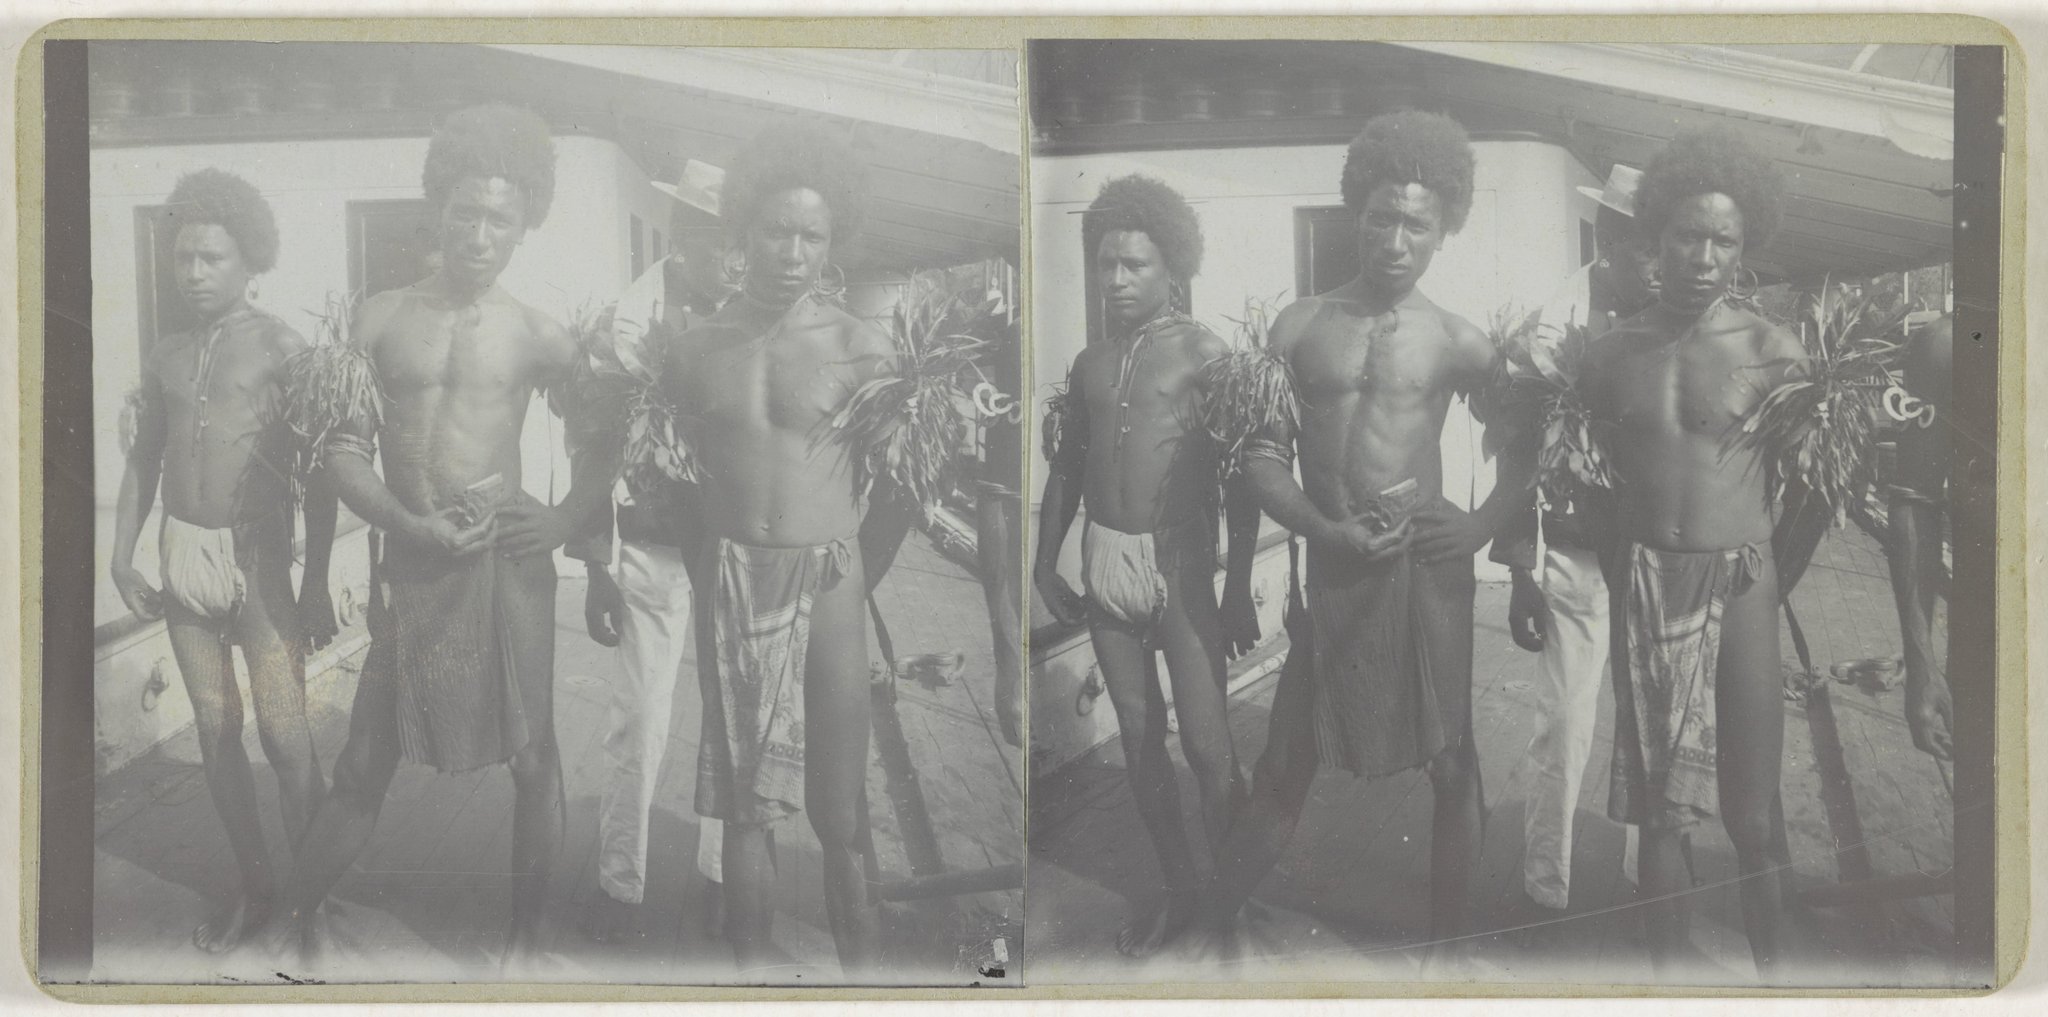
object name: stereograph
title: Drie oorspronkelijke bewoners van Jayapura, West-Nieuw-Guinea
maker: Anonymous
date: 1900-1940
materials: paper, cardboard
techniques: gelatin silver print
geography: jayapura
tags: adult man